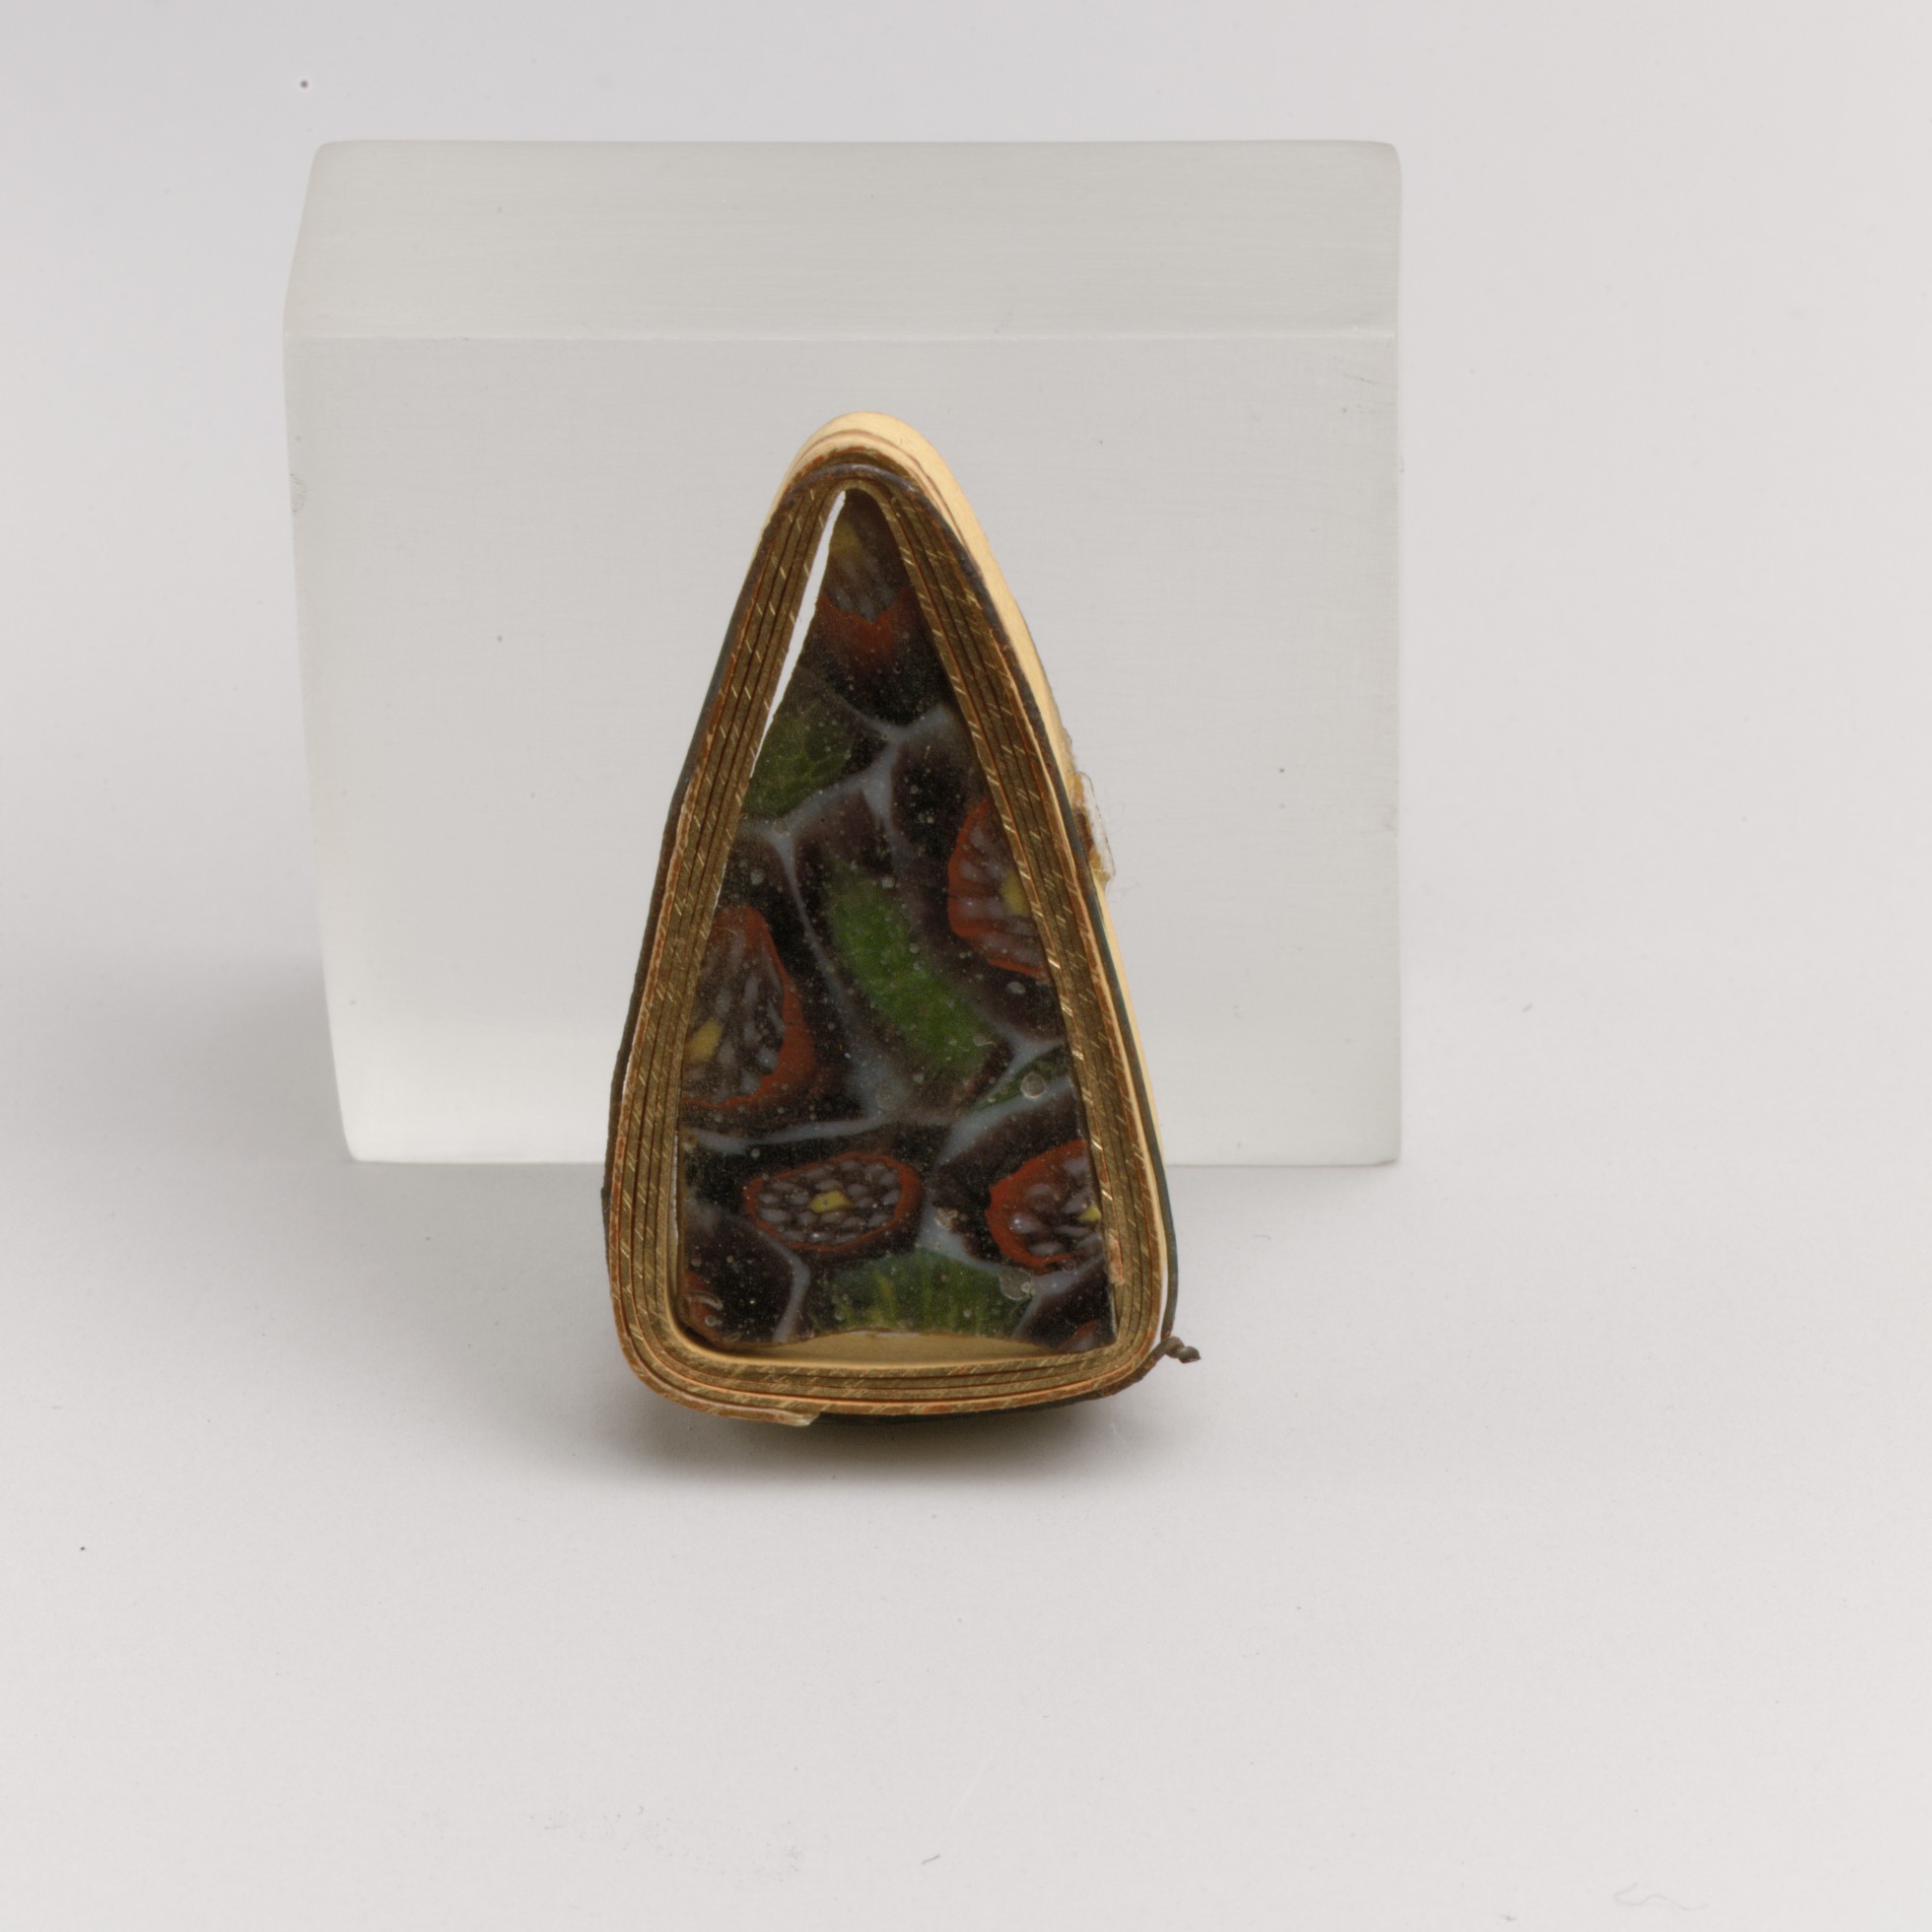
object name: fragment, mosaic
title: Glass mosaic fragment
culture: roman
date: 34 BCE-33 CE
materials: glass